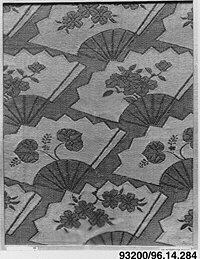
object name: piece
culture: japanese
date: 1701-1900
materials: silk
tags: leaves